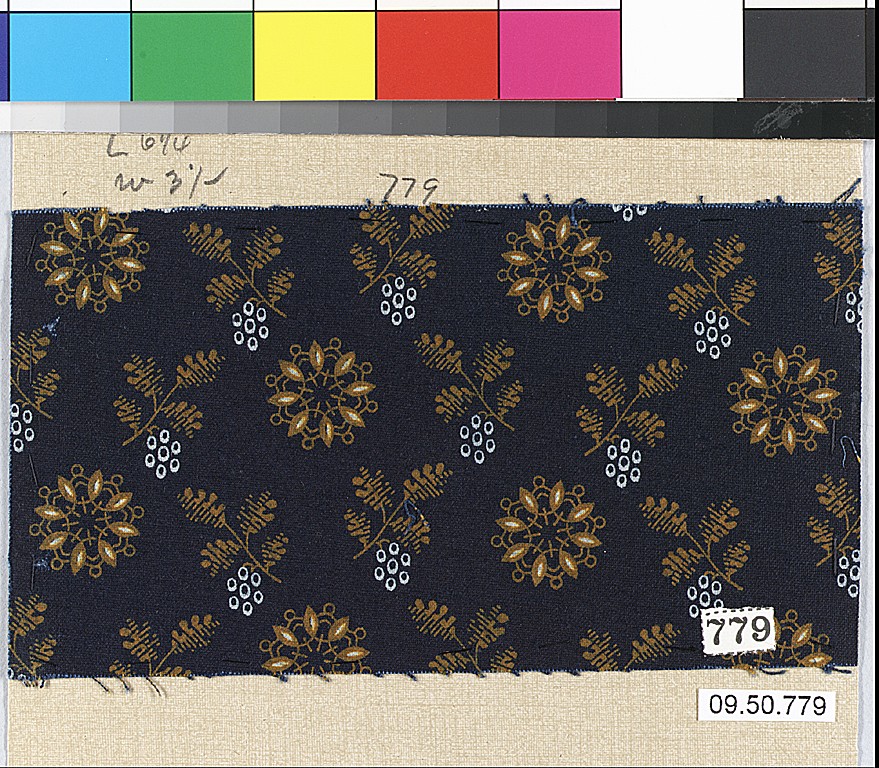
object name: piece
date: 1801-1900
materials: cotton